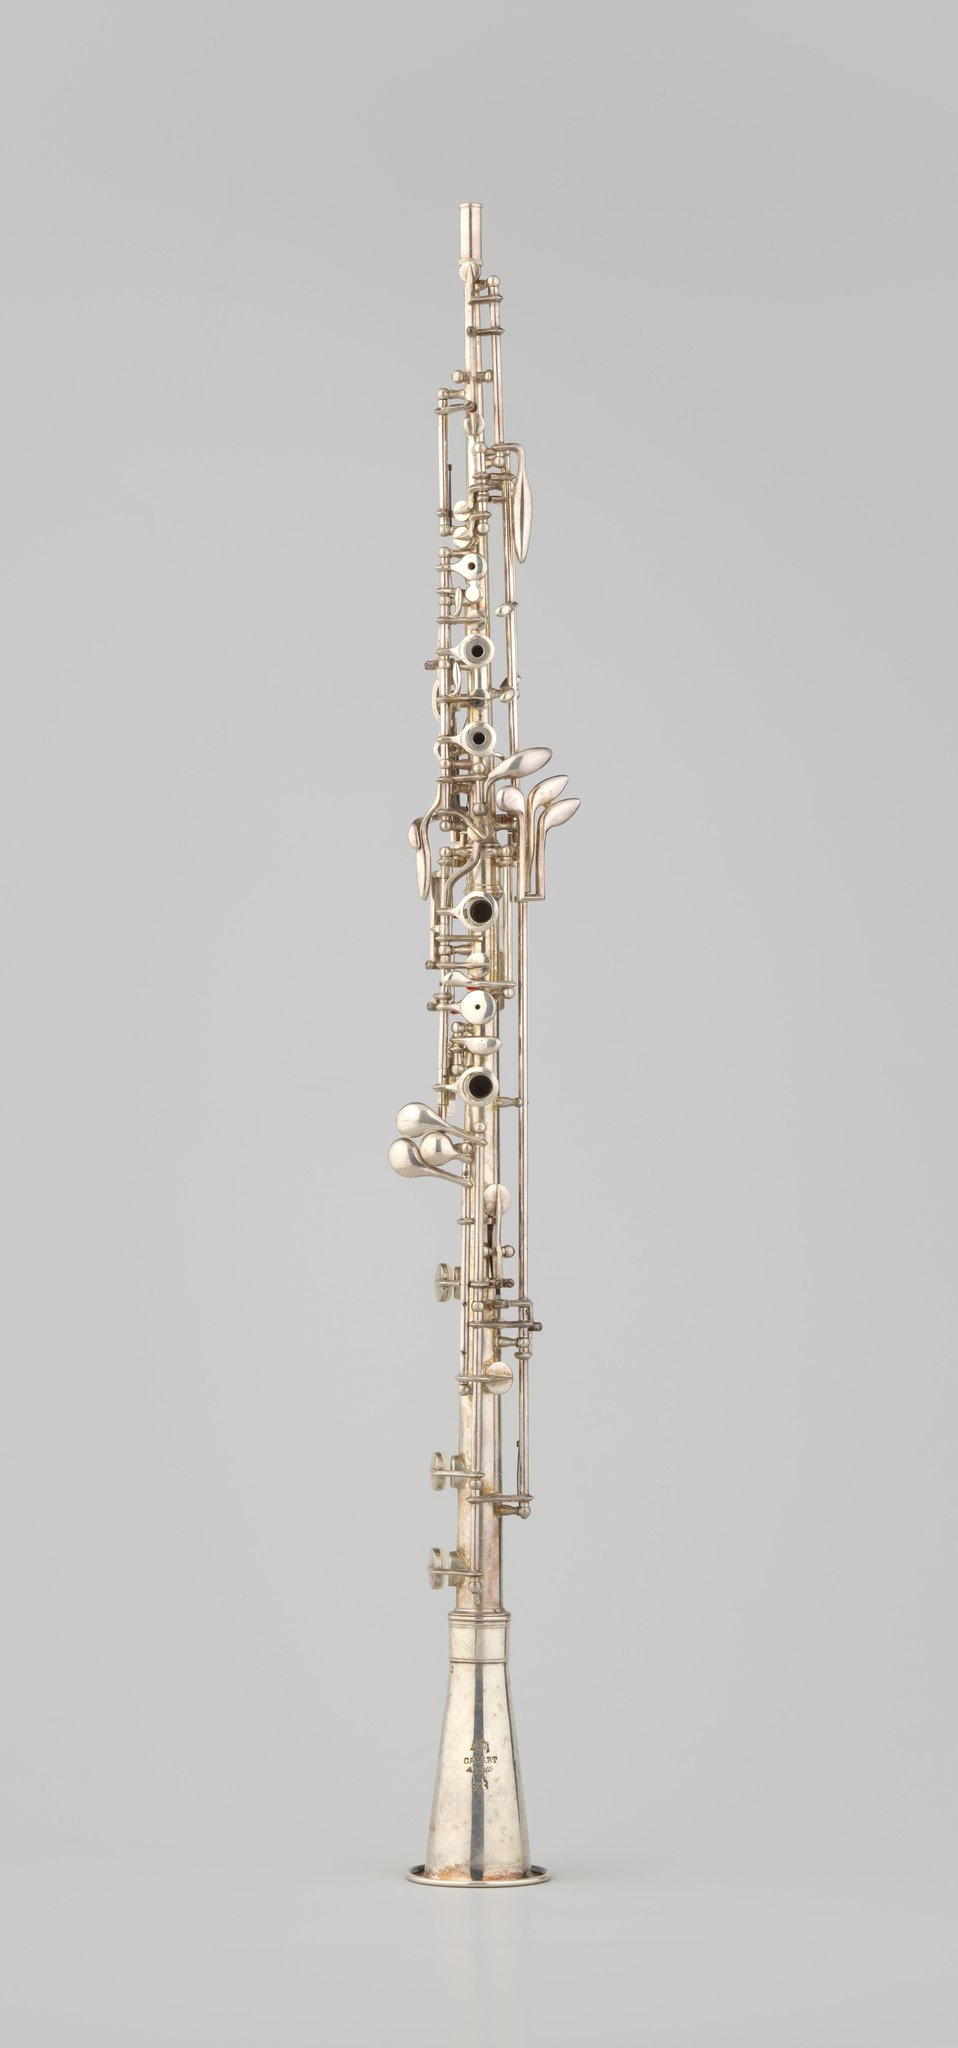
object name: wind instrument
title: Oboe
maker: cabart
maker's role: musical instrument maker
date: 1890-1899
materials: nickel, silver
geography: paris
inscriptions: inscription: ‘[gallioen] / CABART / A PARIS / [kruis /mol / herstellingsteken].’, inscription: ‘FRANCE’, inscription: ‘3’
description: Hobo van nikkel en zilver met 16 kleppen en een vingersteun (gesoldeerd op het middelstuk). Gemarkeerd op de beker [gallioen] / CABART / A PARIS / [kruis /mol / herstellingsteken]. Gemarkeerd op de achterkant van de beker boven het stemmingsgat: FRANCE. Op het onderste gedeelte van het middenstuk staat het cijfer 3.